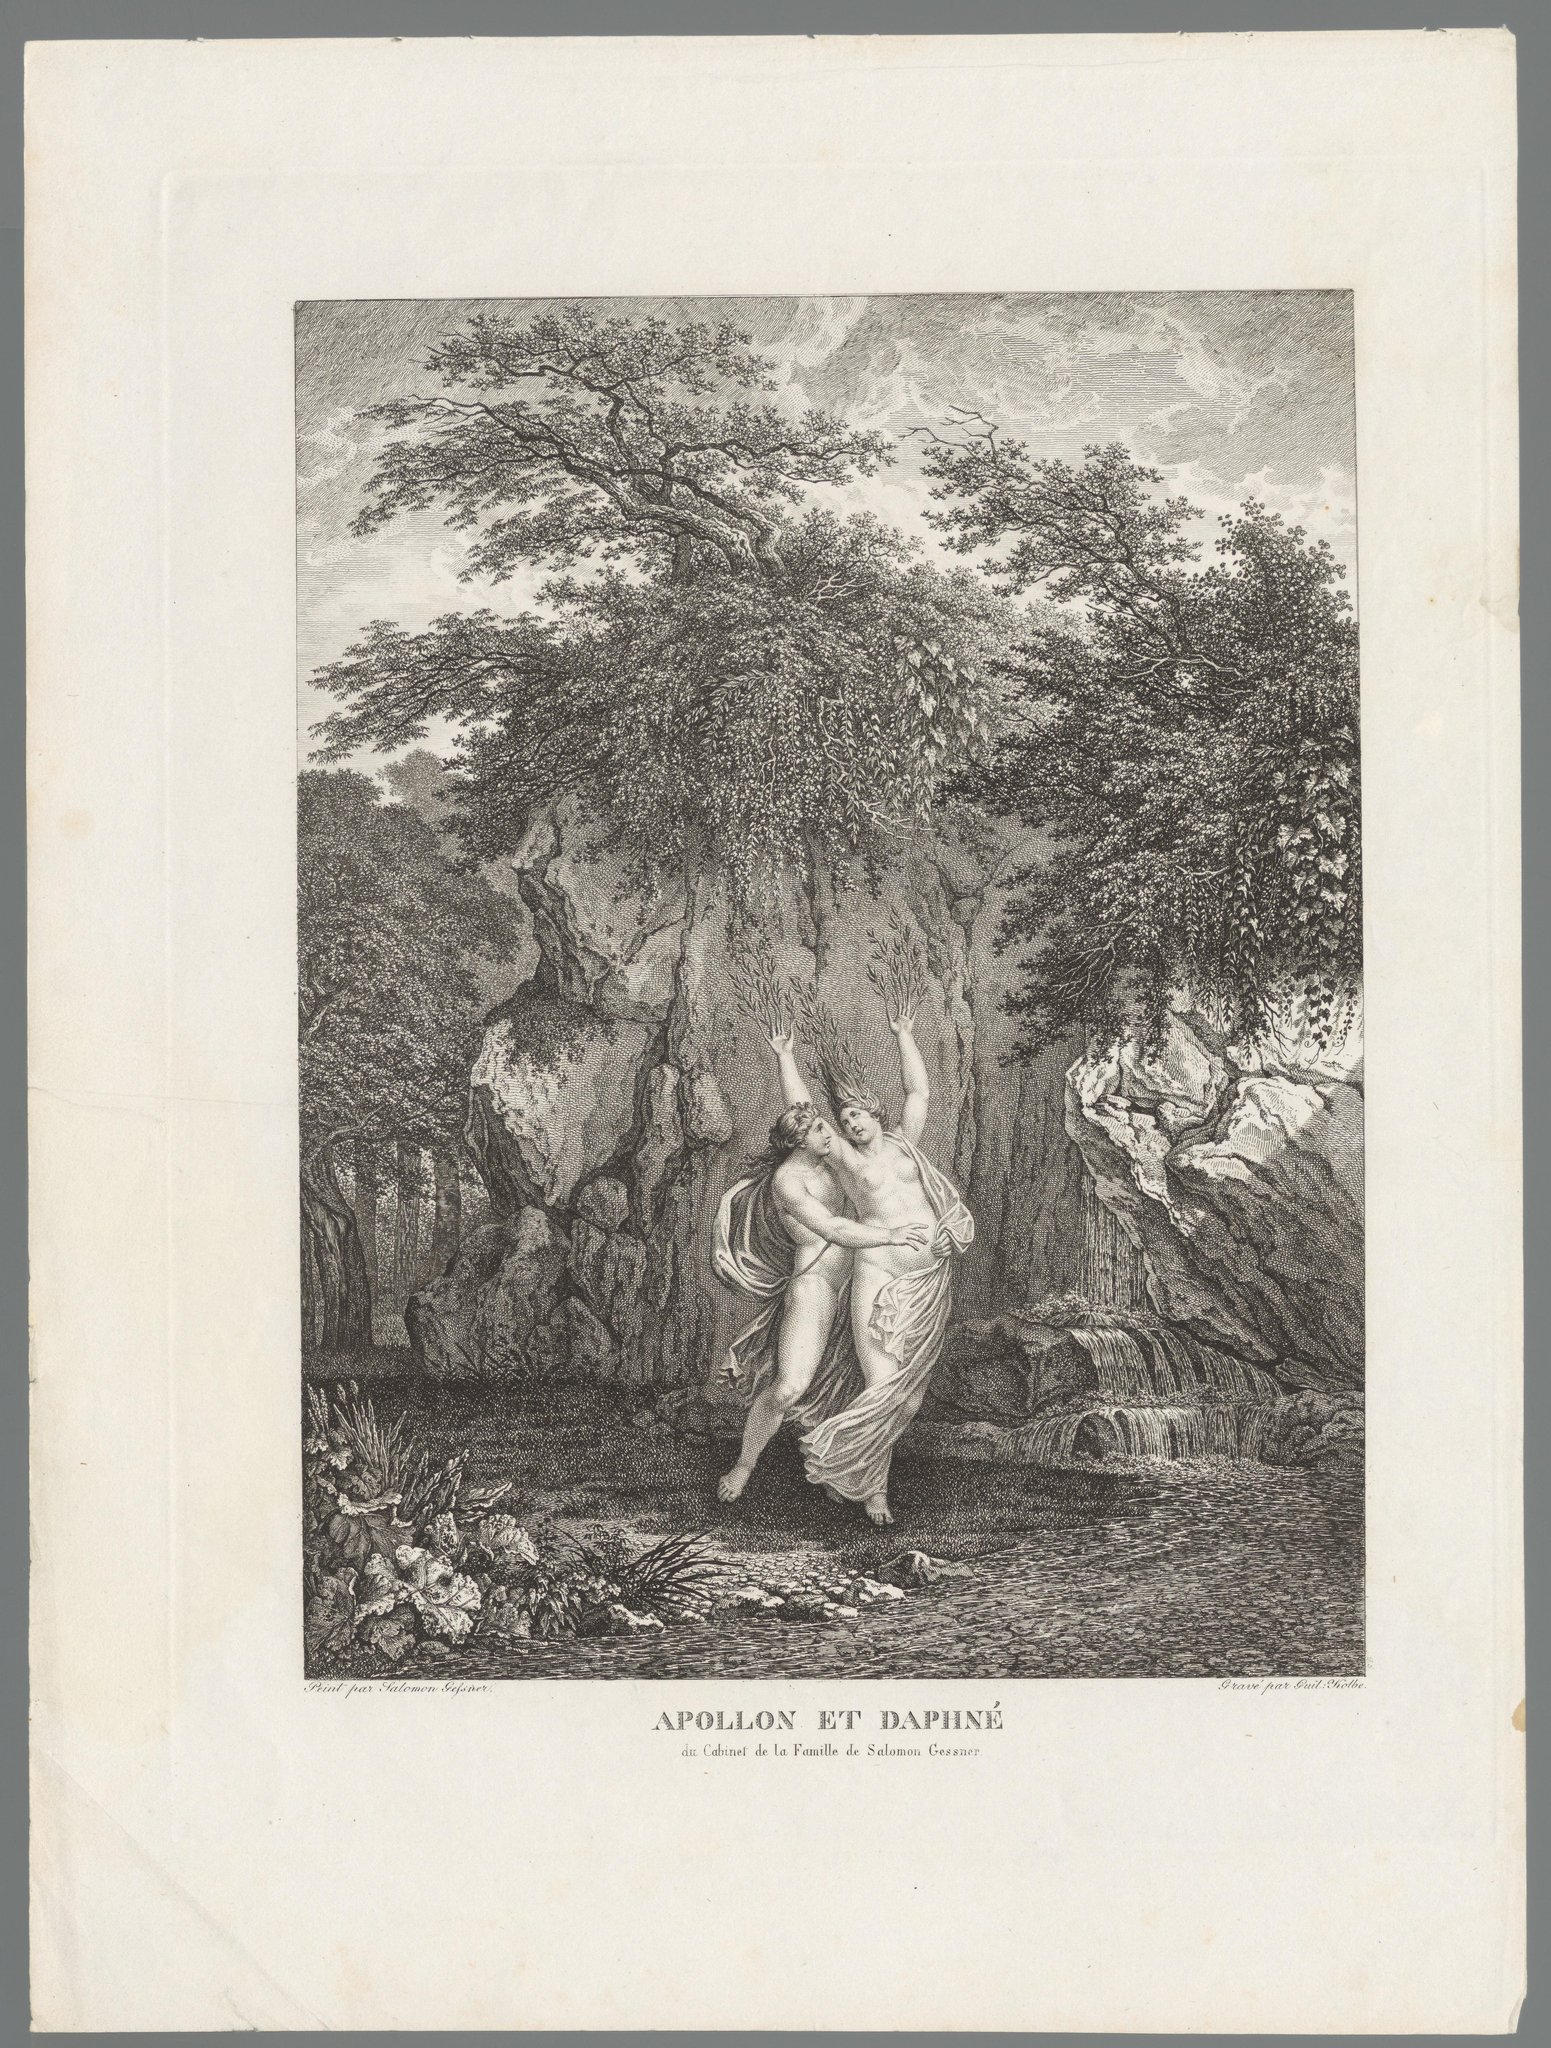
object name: print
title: Verzameling van gouaches en tekeningen geëtst door Wilhelm Kolbe naar ontwerp van Salomon Gessner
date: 1811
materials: paper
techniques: etching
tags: foliage ~ ornament, daphne changed into a laurel-tree: while fleeing from apollo, daphne is changed into a laurel-tree by her father peneus (ovid, metamorphoses i 548)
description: Deze prent is gemaakt voor een serie uit 1811 getiteld: Collection des tableaux en gouache et des dessins de Salomon Gessner. Gravés à l'eau forte par Guil. Kolbe. De gehele serie is in het bezit van het RMA onder inv. nr. RP-P-2005-184.